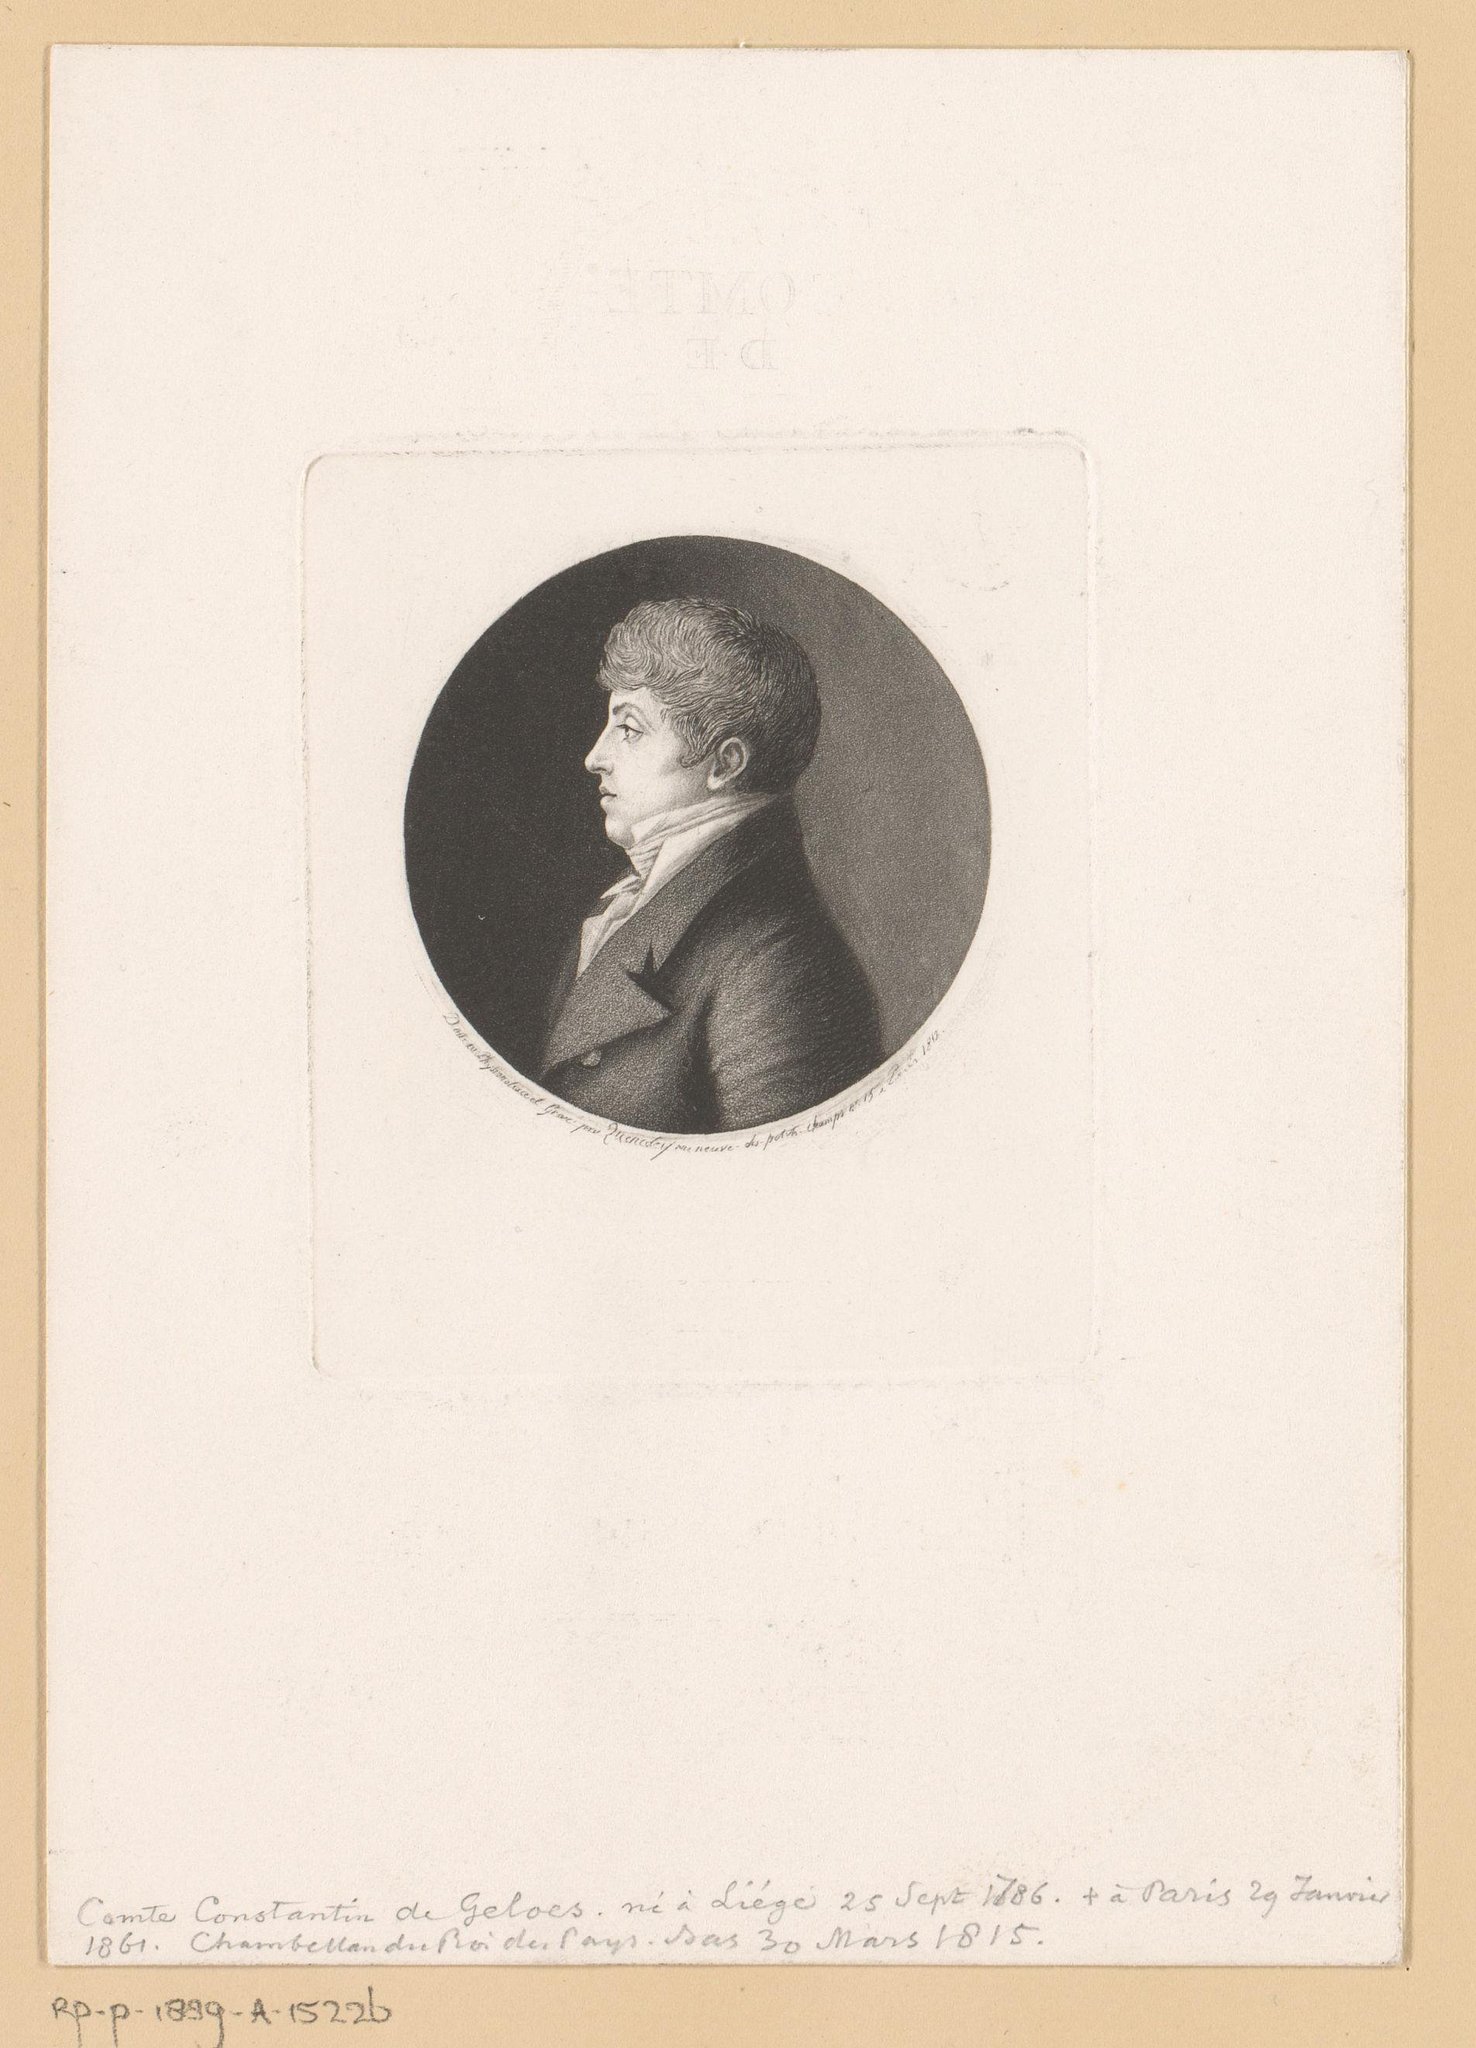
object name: physionotrace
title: Portret van Constantin de Geloes d'Eysden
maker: edme quenedey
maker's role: print maker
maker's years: 1756-1830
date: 1812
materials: paper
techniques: aquatint, etching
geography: paris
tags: liège, silhouette-apparatus, 'physionotrace', historical persons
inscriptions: collector's mark: Lugt 2228